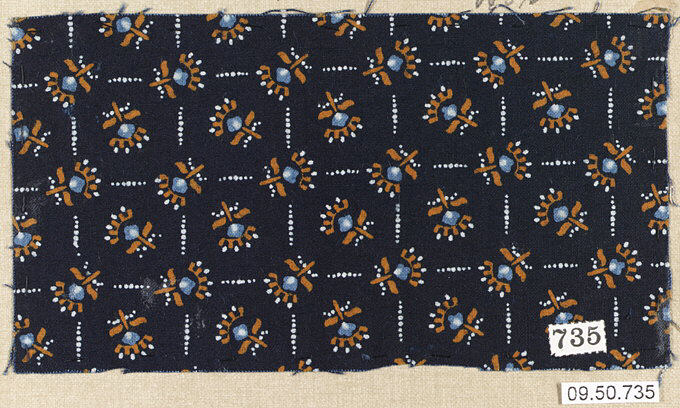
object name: piece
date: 1801-1900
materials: cotton